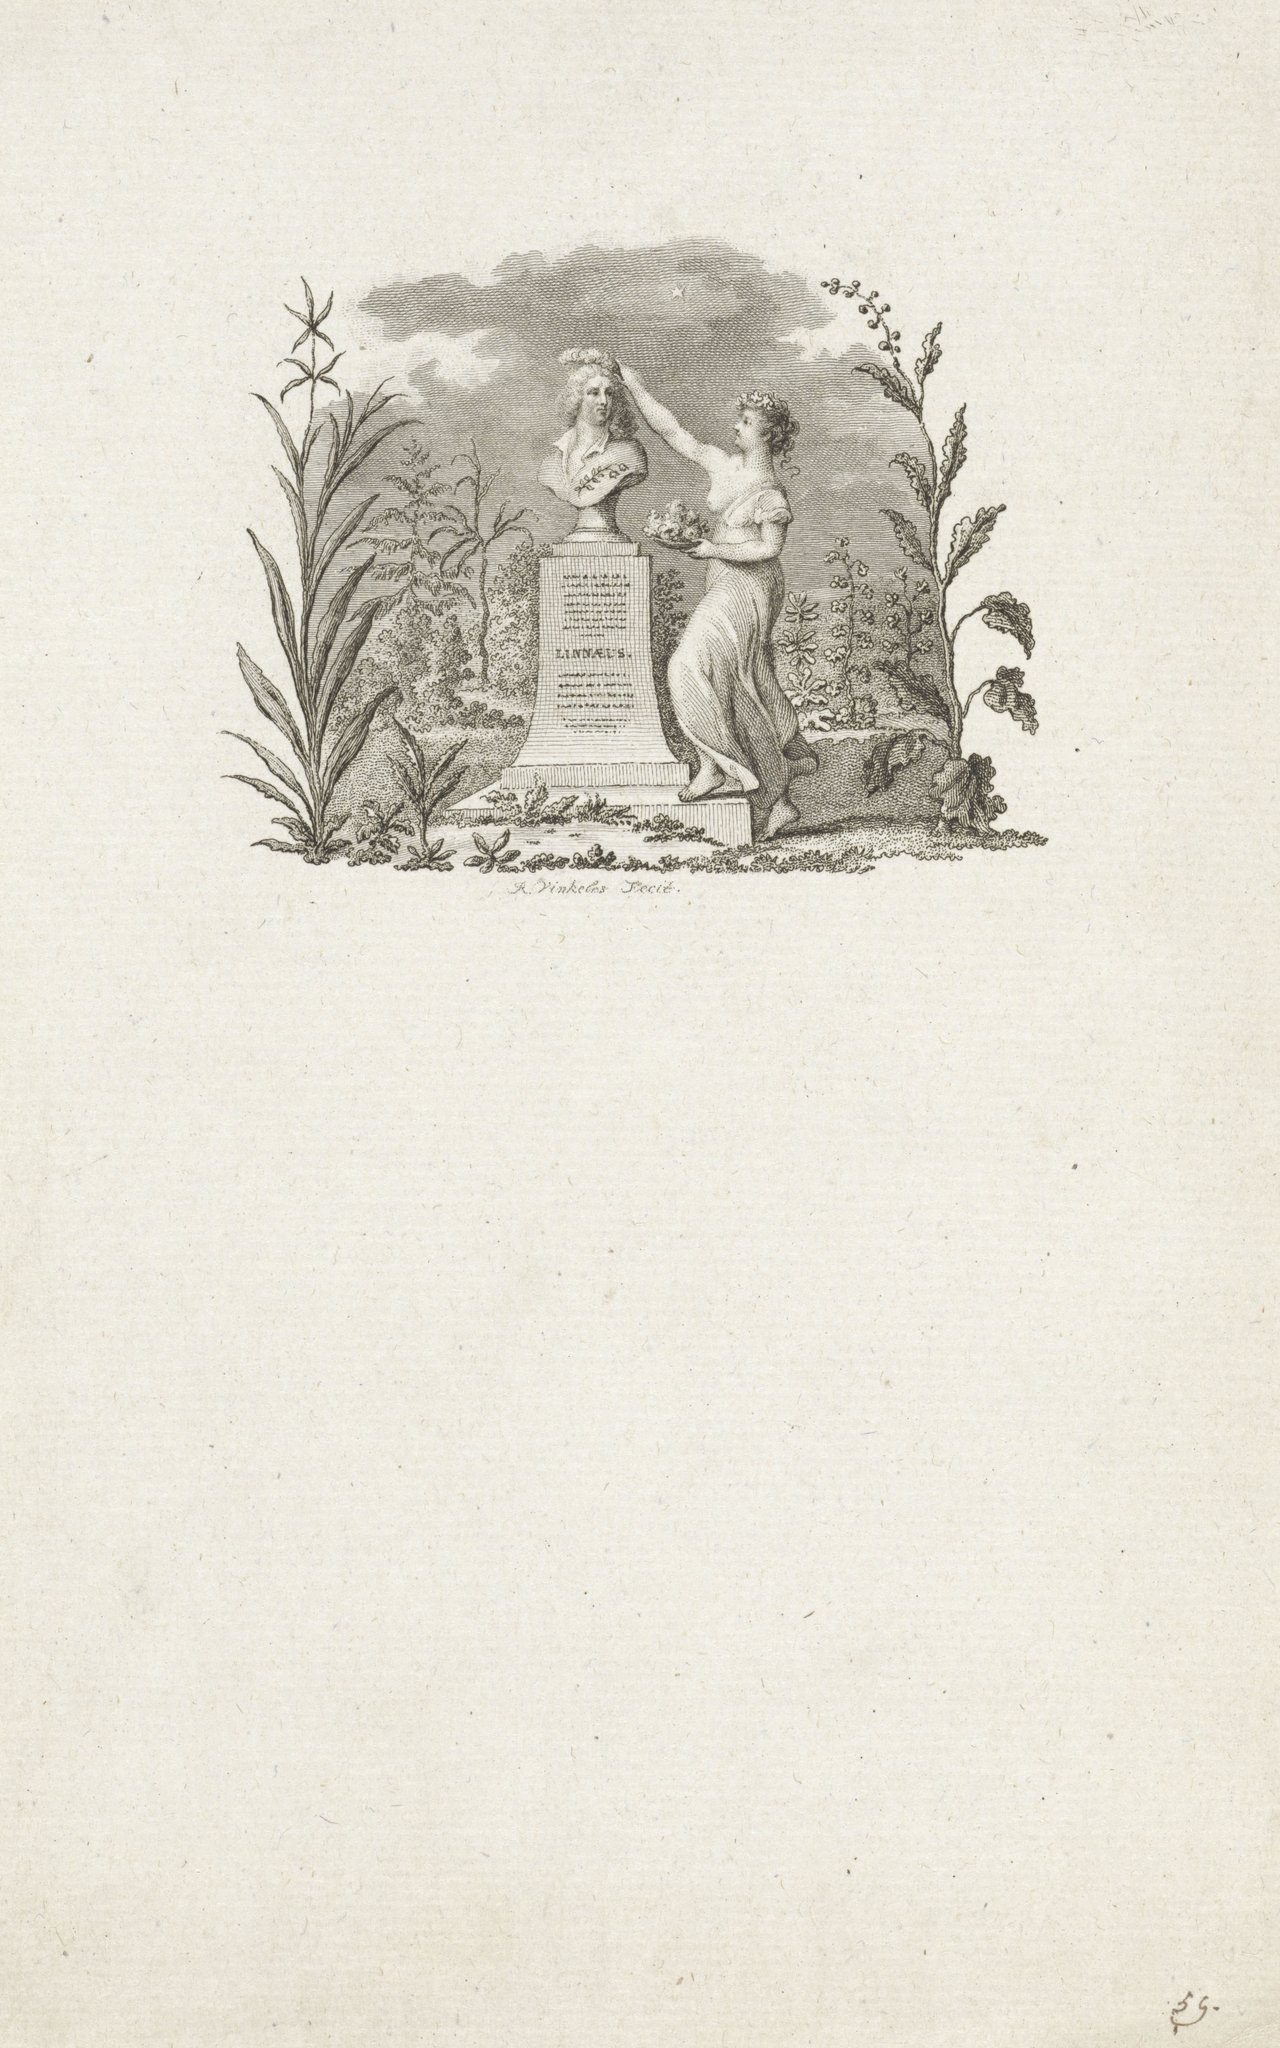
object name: print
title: Gekroonde buste van Carolus Linnaeus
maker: reinier vinkeles (i)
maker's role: draughtsman, print maker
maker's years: 1741-1816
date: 1751-1816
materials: paper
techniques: engraving, etching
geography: amsterdam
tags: carl linnaeus, landscapes, crowning with laurel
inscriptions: collector's mark: Lugt 2228